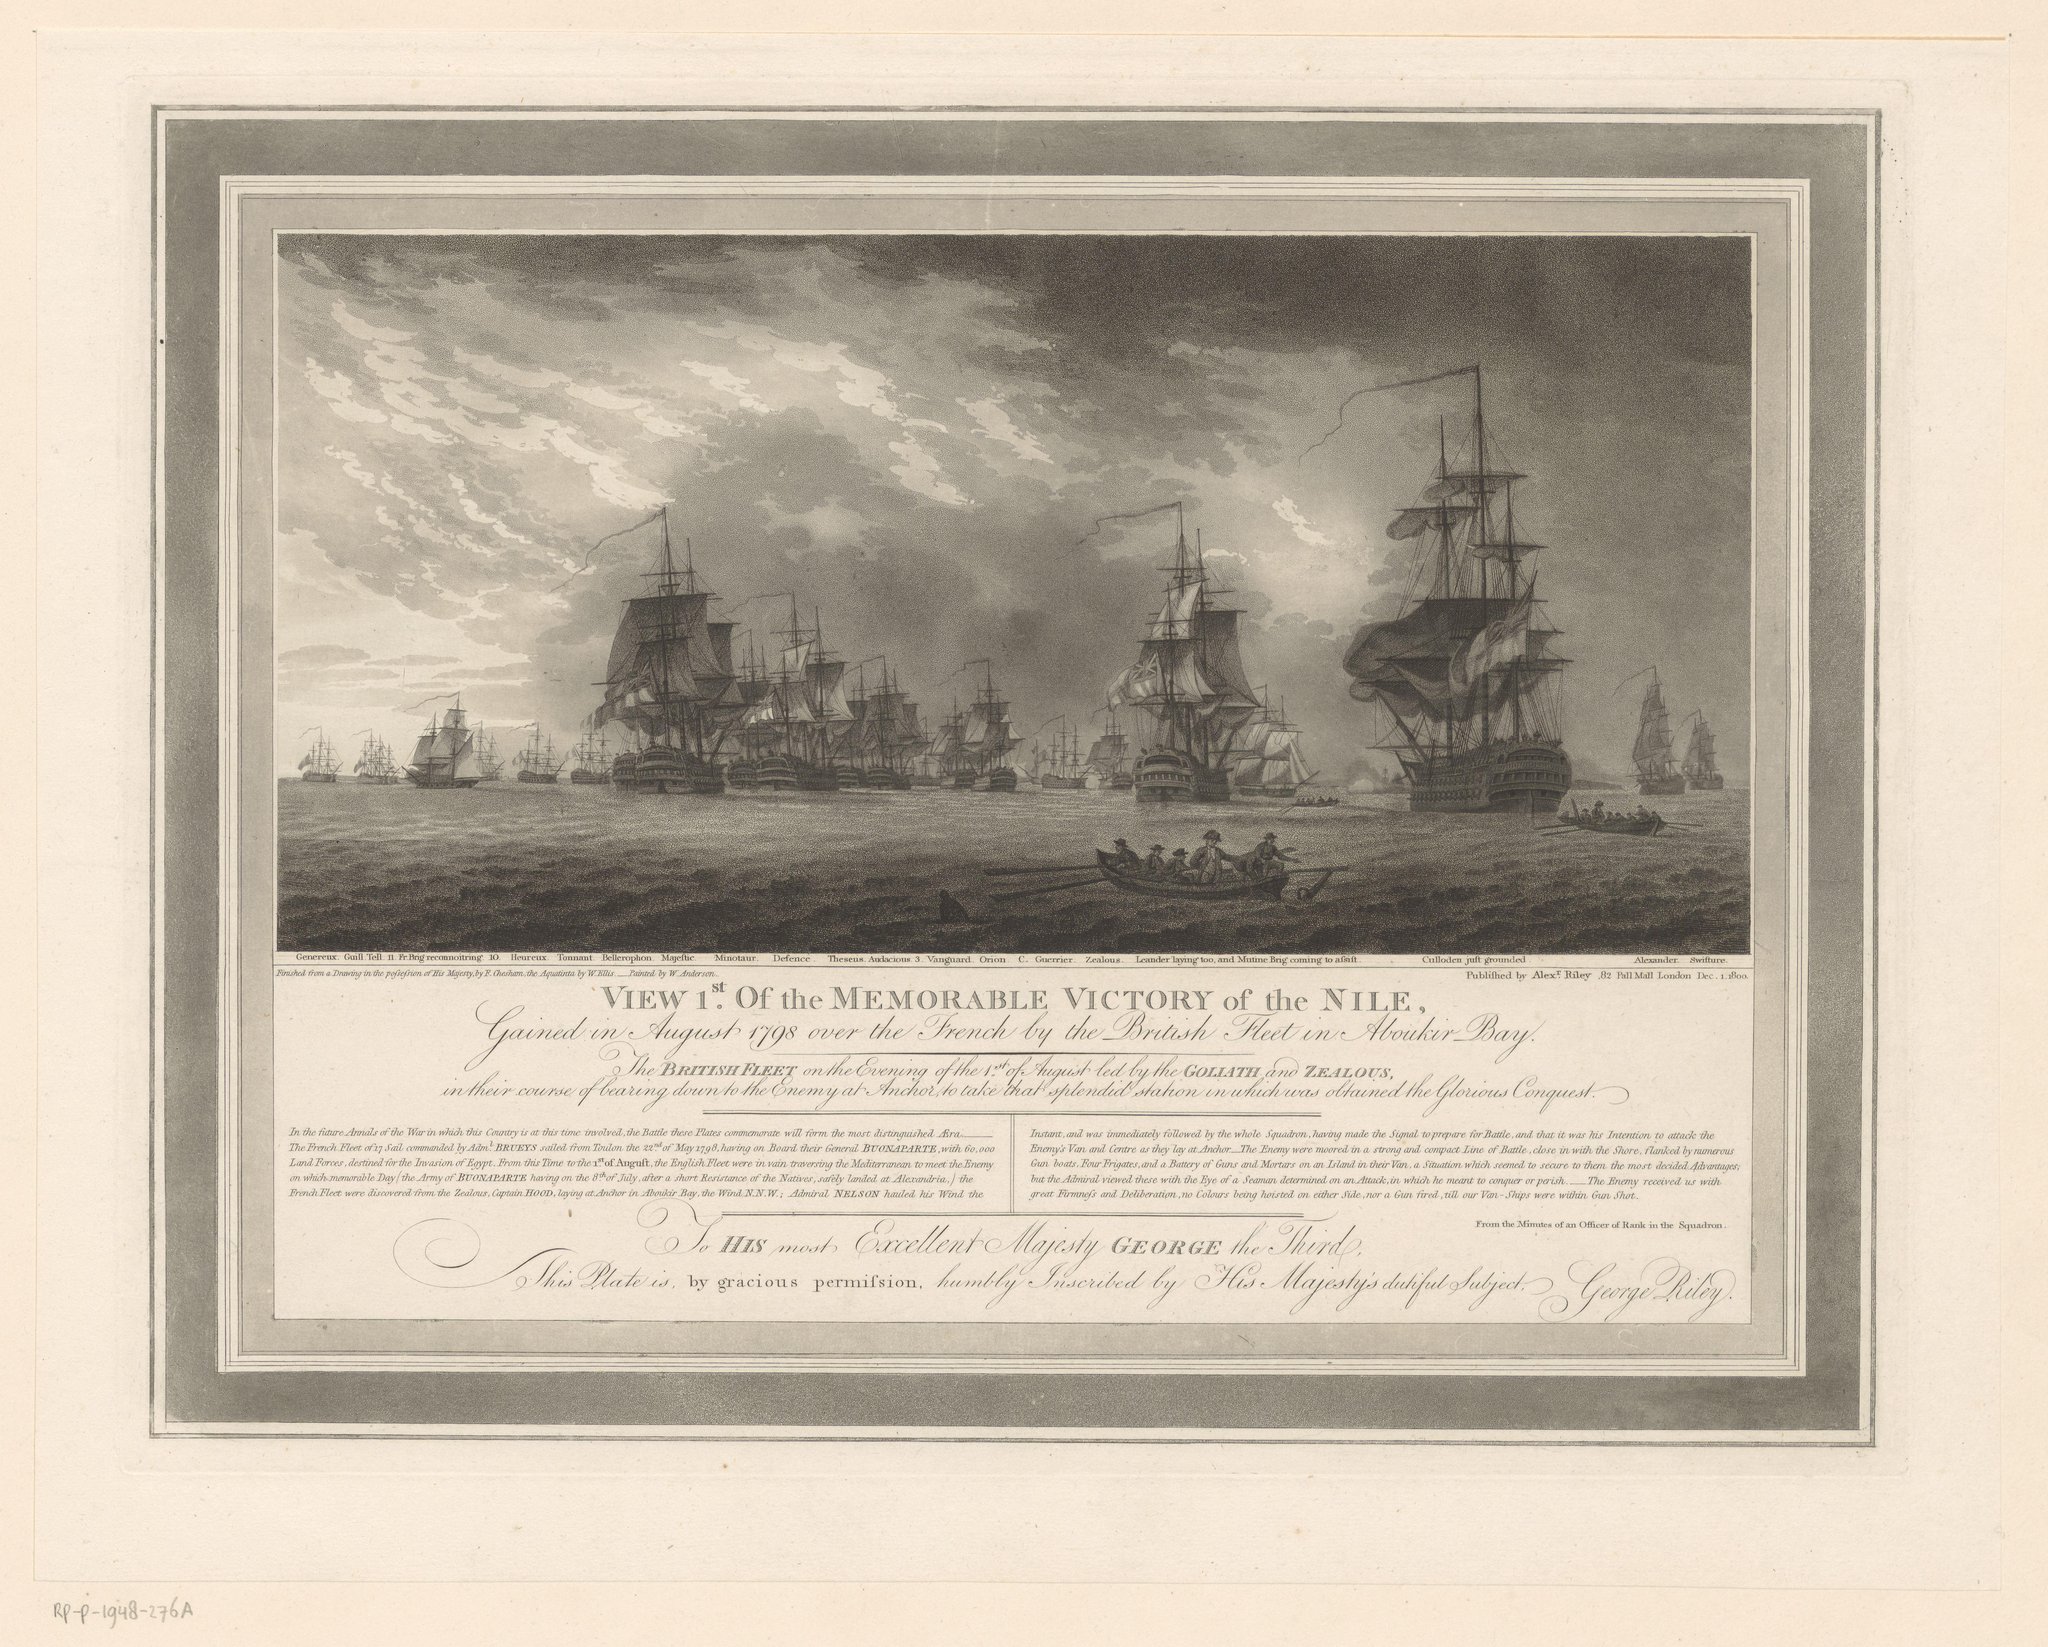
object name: print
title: Vier gezichten op de Nijl tijdens de Slag bij de Nijl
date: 1800-1812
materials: paper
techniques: aquatint, etching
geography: london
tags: horatio nelson (hertog van bronte), sailing-ship, sailing-boat, battle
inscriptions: collector's mark: Lugt 2228